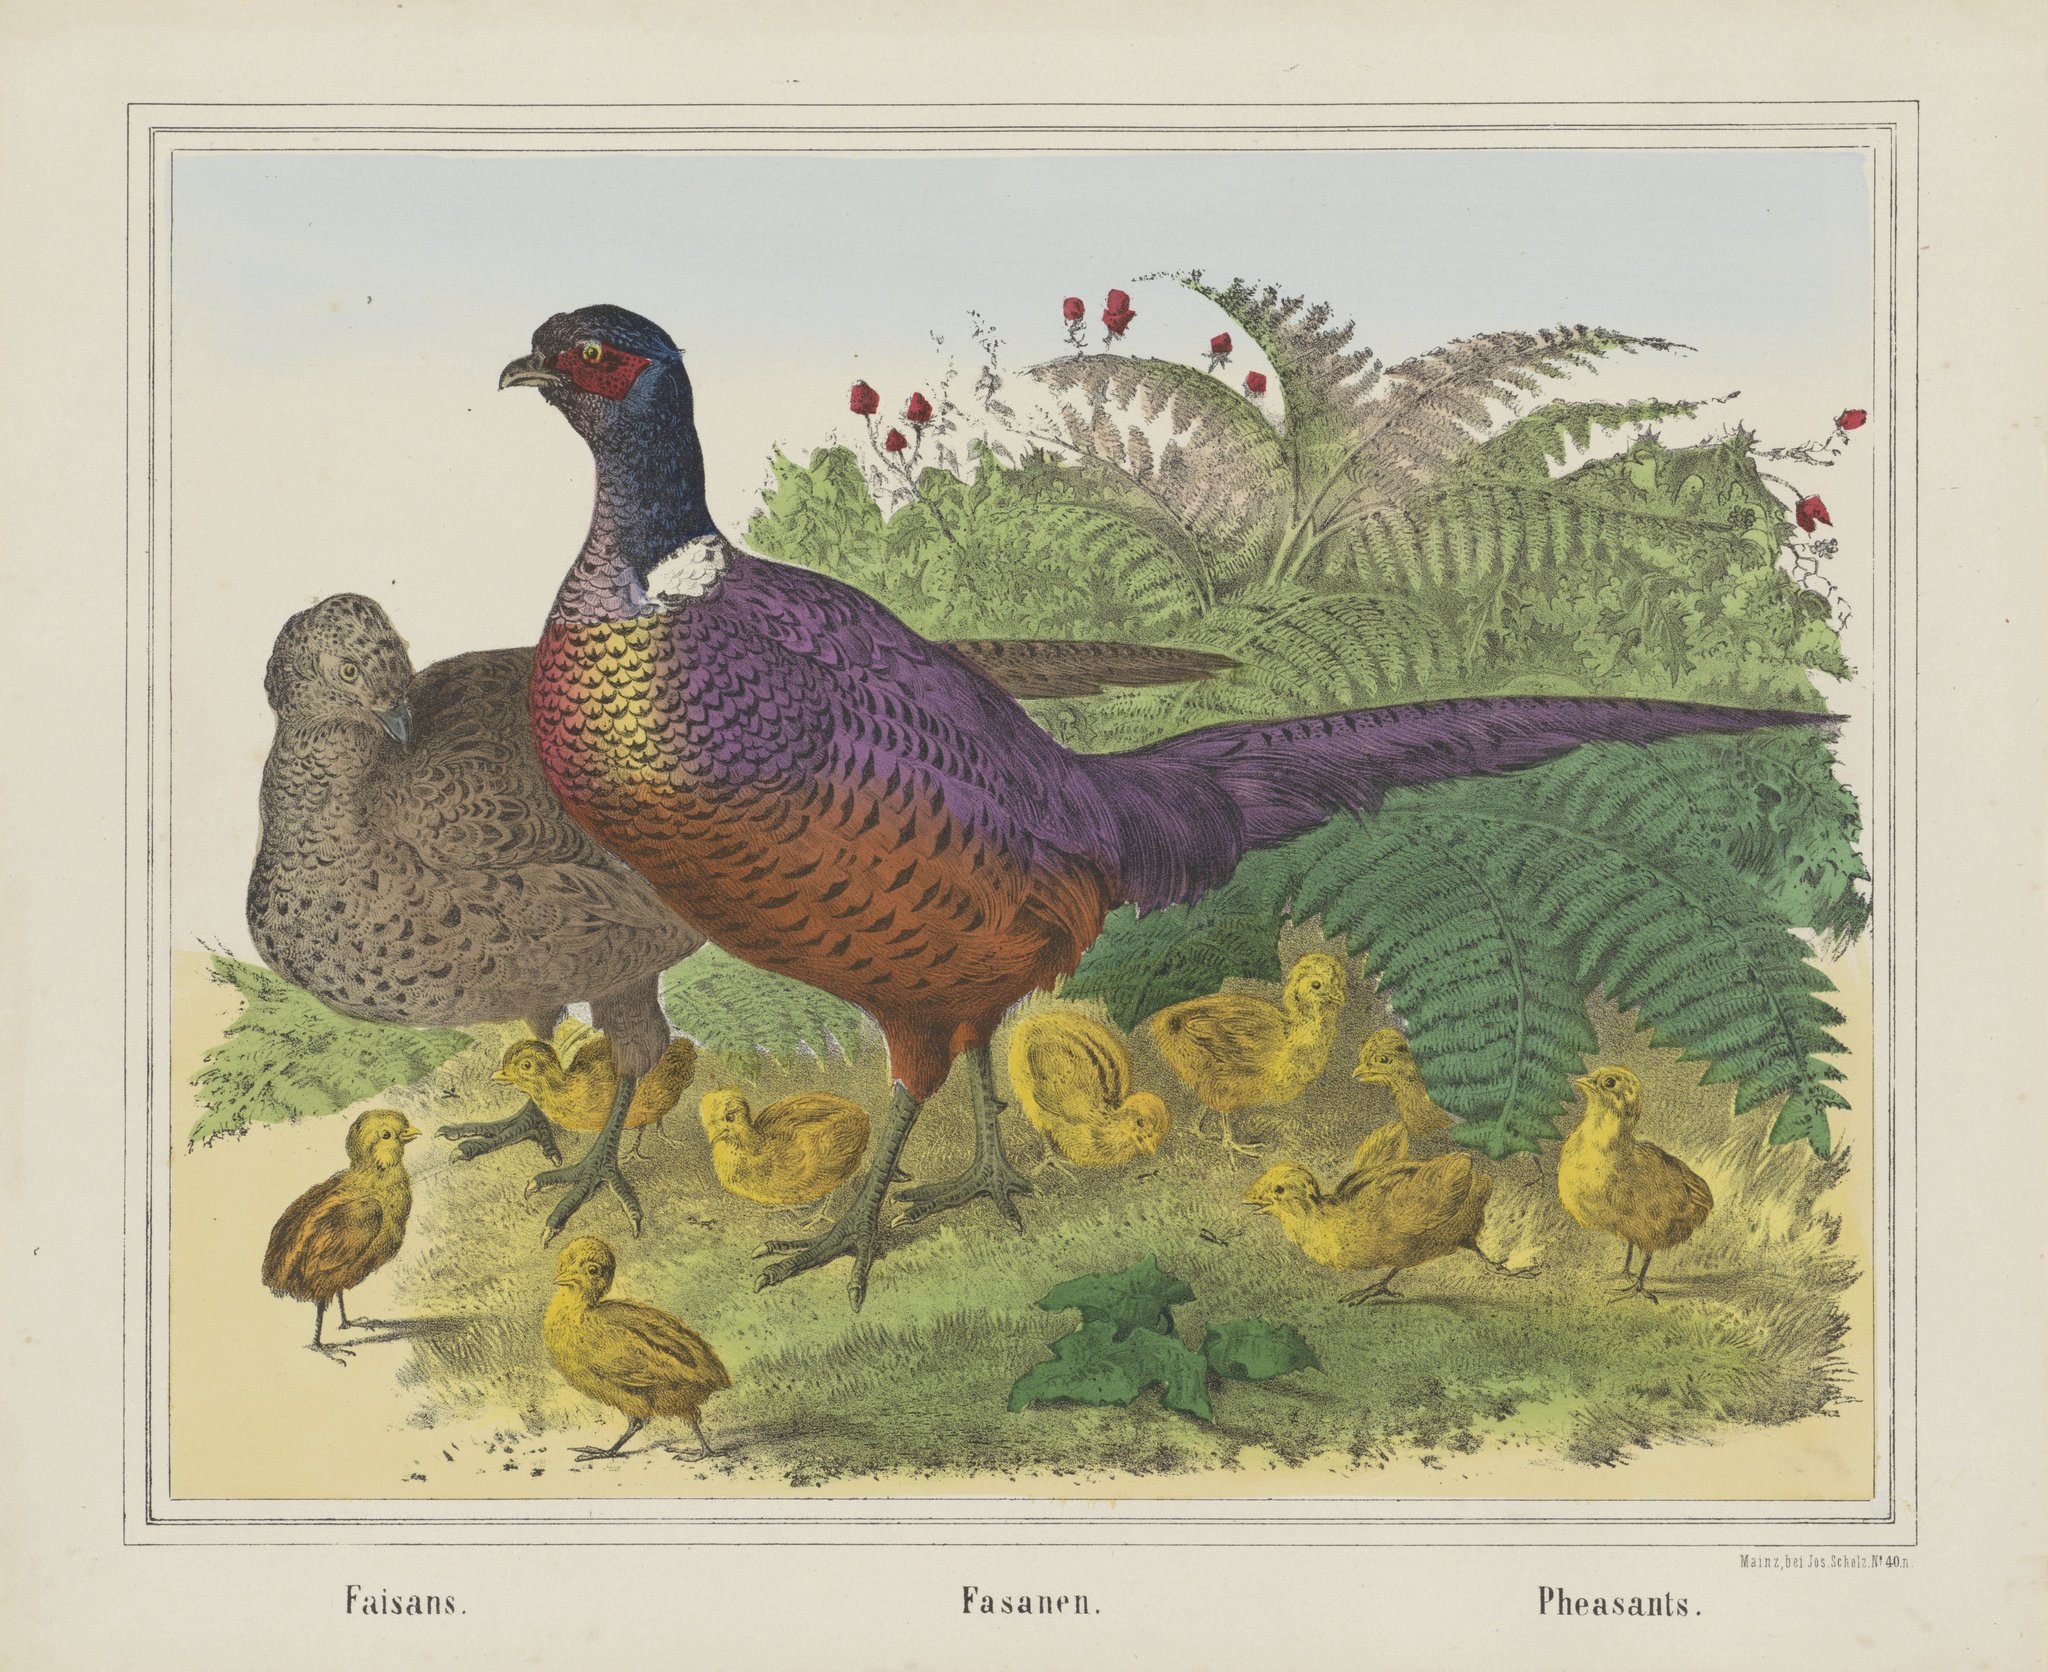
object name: print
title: Faisans. / Fasanen. / Pheasants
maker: Anonymous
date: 1829-1880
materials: paper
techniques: colour, letterpress printing, lithograph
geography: europe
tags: walker and runner birds: pheasant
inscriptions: collector's mark: Lugt 2760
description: Mannetjes en vrouwtjes fazant met negen kuikens voor een bos varens. Genummerd rechtsonder: No. 40n.